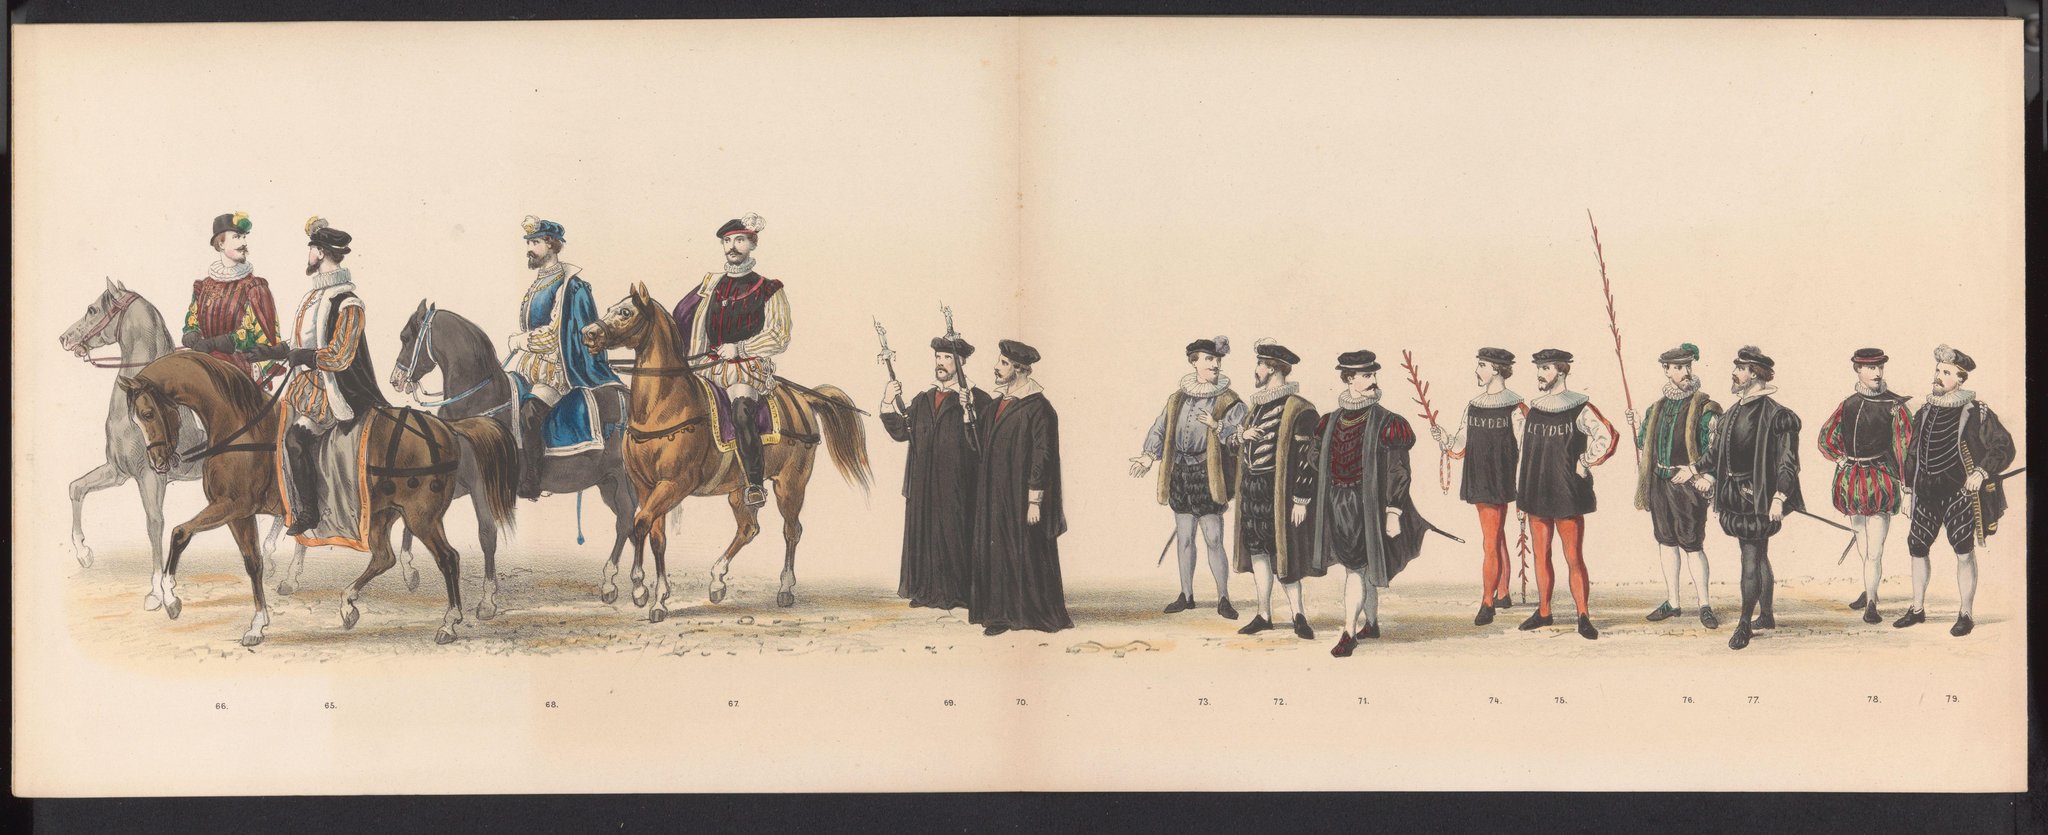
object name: print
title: Maskerade van de Leidse studenten, 1870 (plaat 6)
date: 1870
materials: paper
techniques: hand coloring, lithograph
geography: netherlands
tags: robert dudley (1st earl of leicester), students' pageant, costumes used in pageants, leiden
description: Historische gekostumeerde optocht van de studenten van de Leidse Hogeschool gehouden op 7 juni 1870 ter gelegenheid van het 295-jarig bestaan van de Hogeschool. De optocht verbeeldt de intocht van de Graaf van Leicester in Leiden in 1586. Zesde plaat met de groepen genummerd 65-79. Onderdeel van de serie van 18 aaneen geplakte bladen.